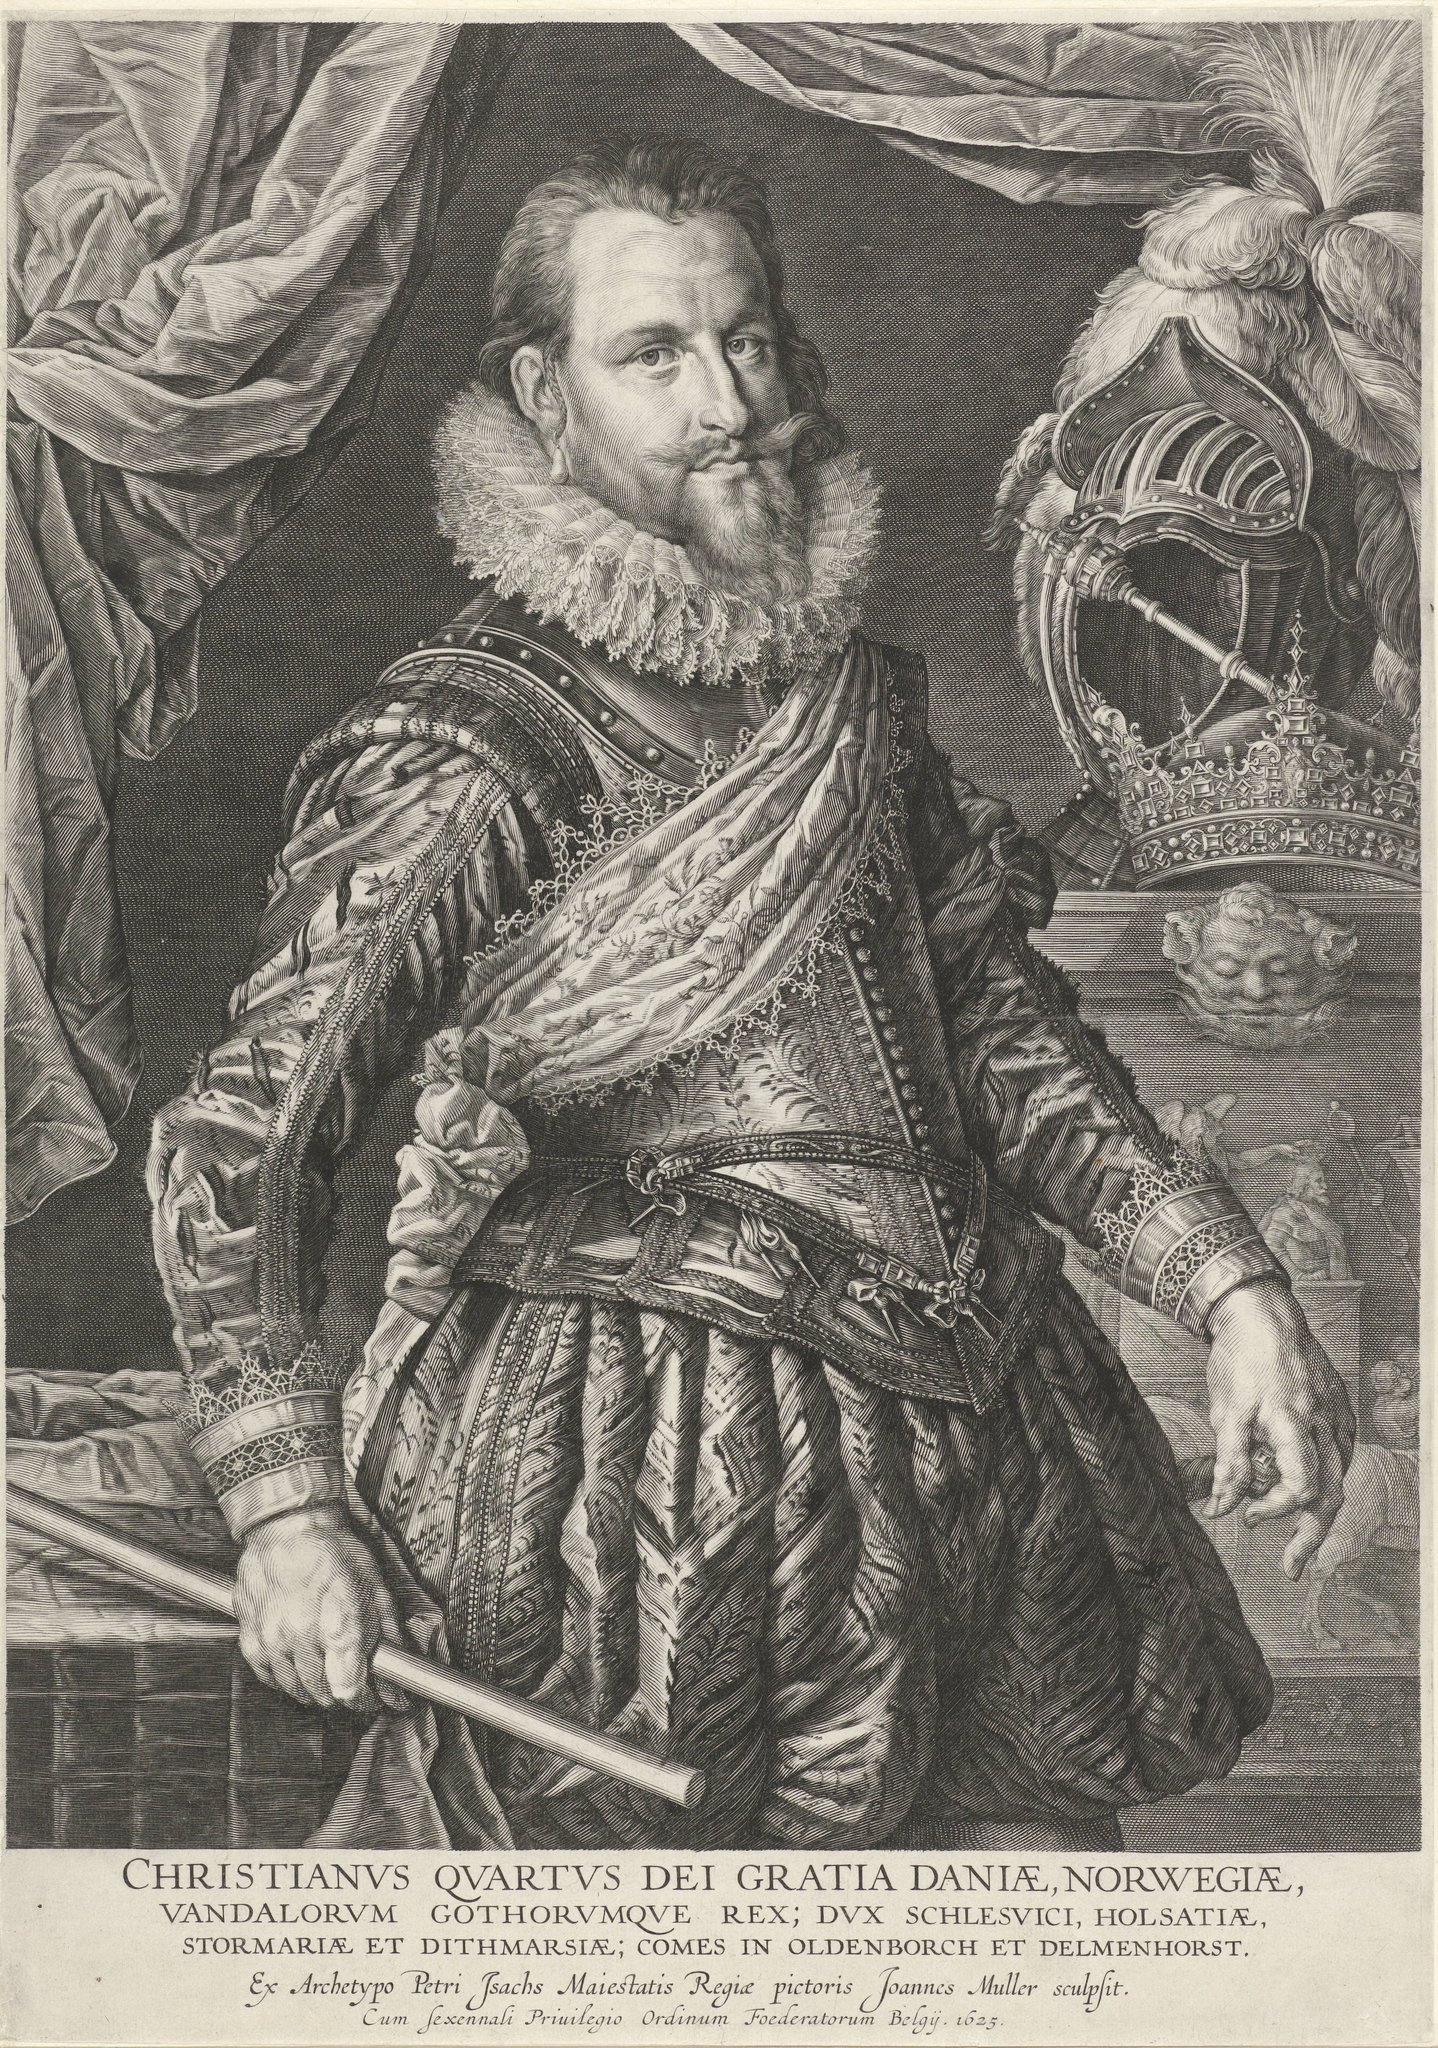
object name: print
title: Portret van koning Christiaan IV van Denemarken en Noorwegen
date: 1625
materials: paper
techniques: engraving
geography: amsterdam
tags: copenhagen (city), christiaan iv (koning van denemarken en noorwegen), insignia and symbols of sovereignty (crown, diadem, sceptre, orb, seal, standard, cloak, pectoral)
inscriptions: collector's mark: Lugt 240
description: Portret van Christiaan IV, koning van Denemarken en Noorwegen, met een sjerp over de schouder en een bevelhebbersstaf in zijn hand, staande onder een open gordijn. Rechts zijn helm, kroon en scepter. Daaronder een reliëf met de voorstelling van een koning die wordt gelauwerd. Onderaan in de marge zijn naam en titels in het Latijn.